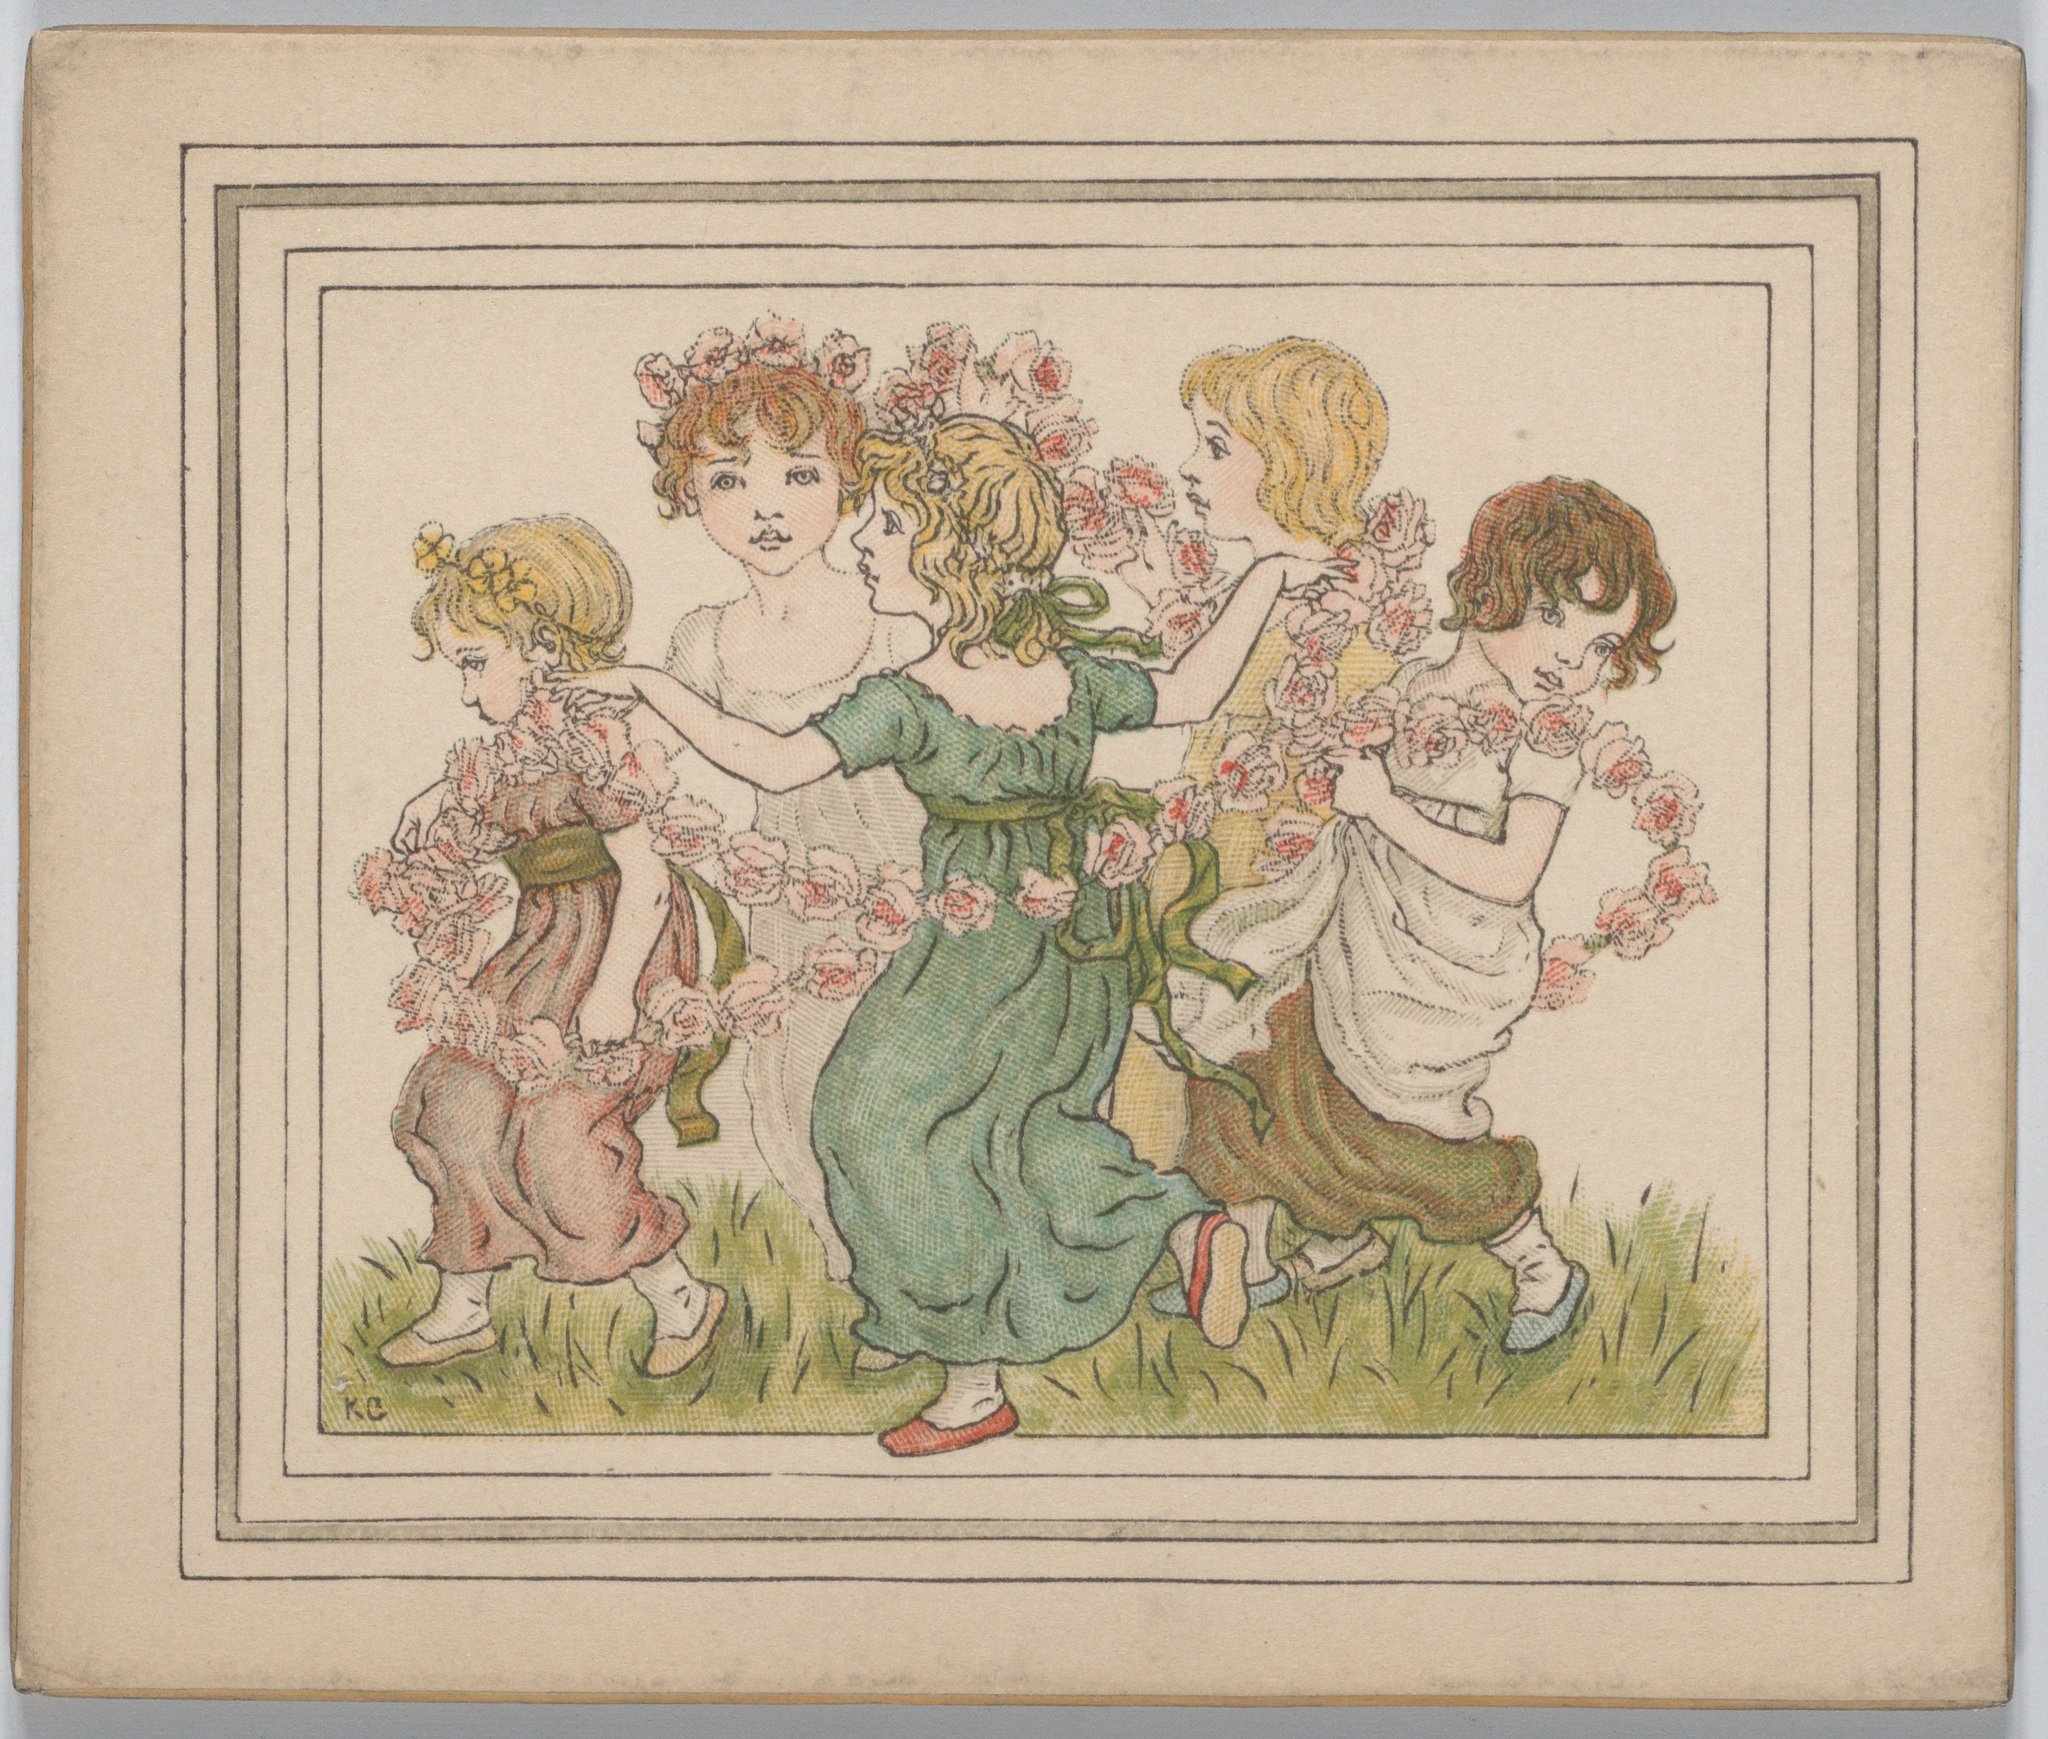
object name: valentine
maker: kate greenaway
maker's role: artist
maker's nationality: british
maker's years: 1846-1901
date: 1880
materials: gilt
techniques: chromolithography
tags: girls